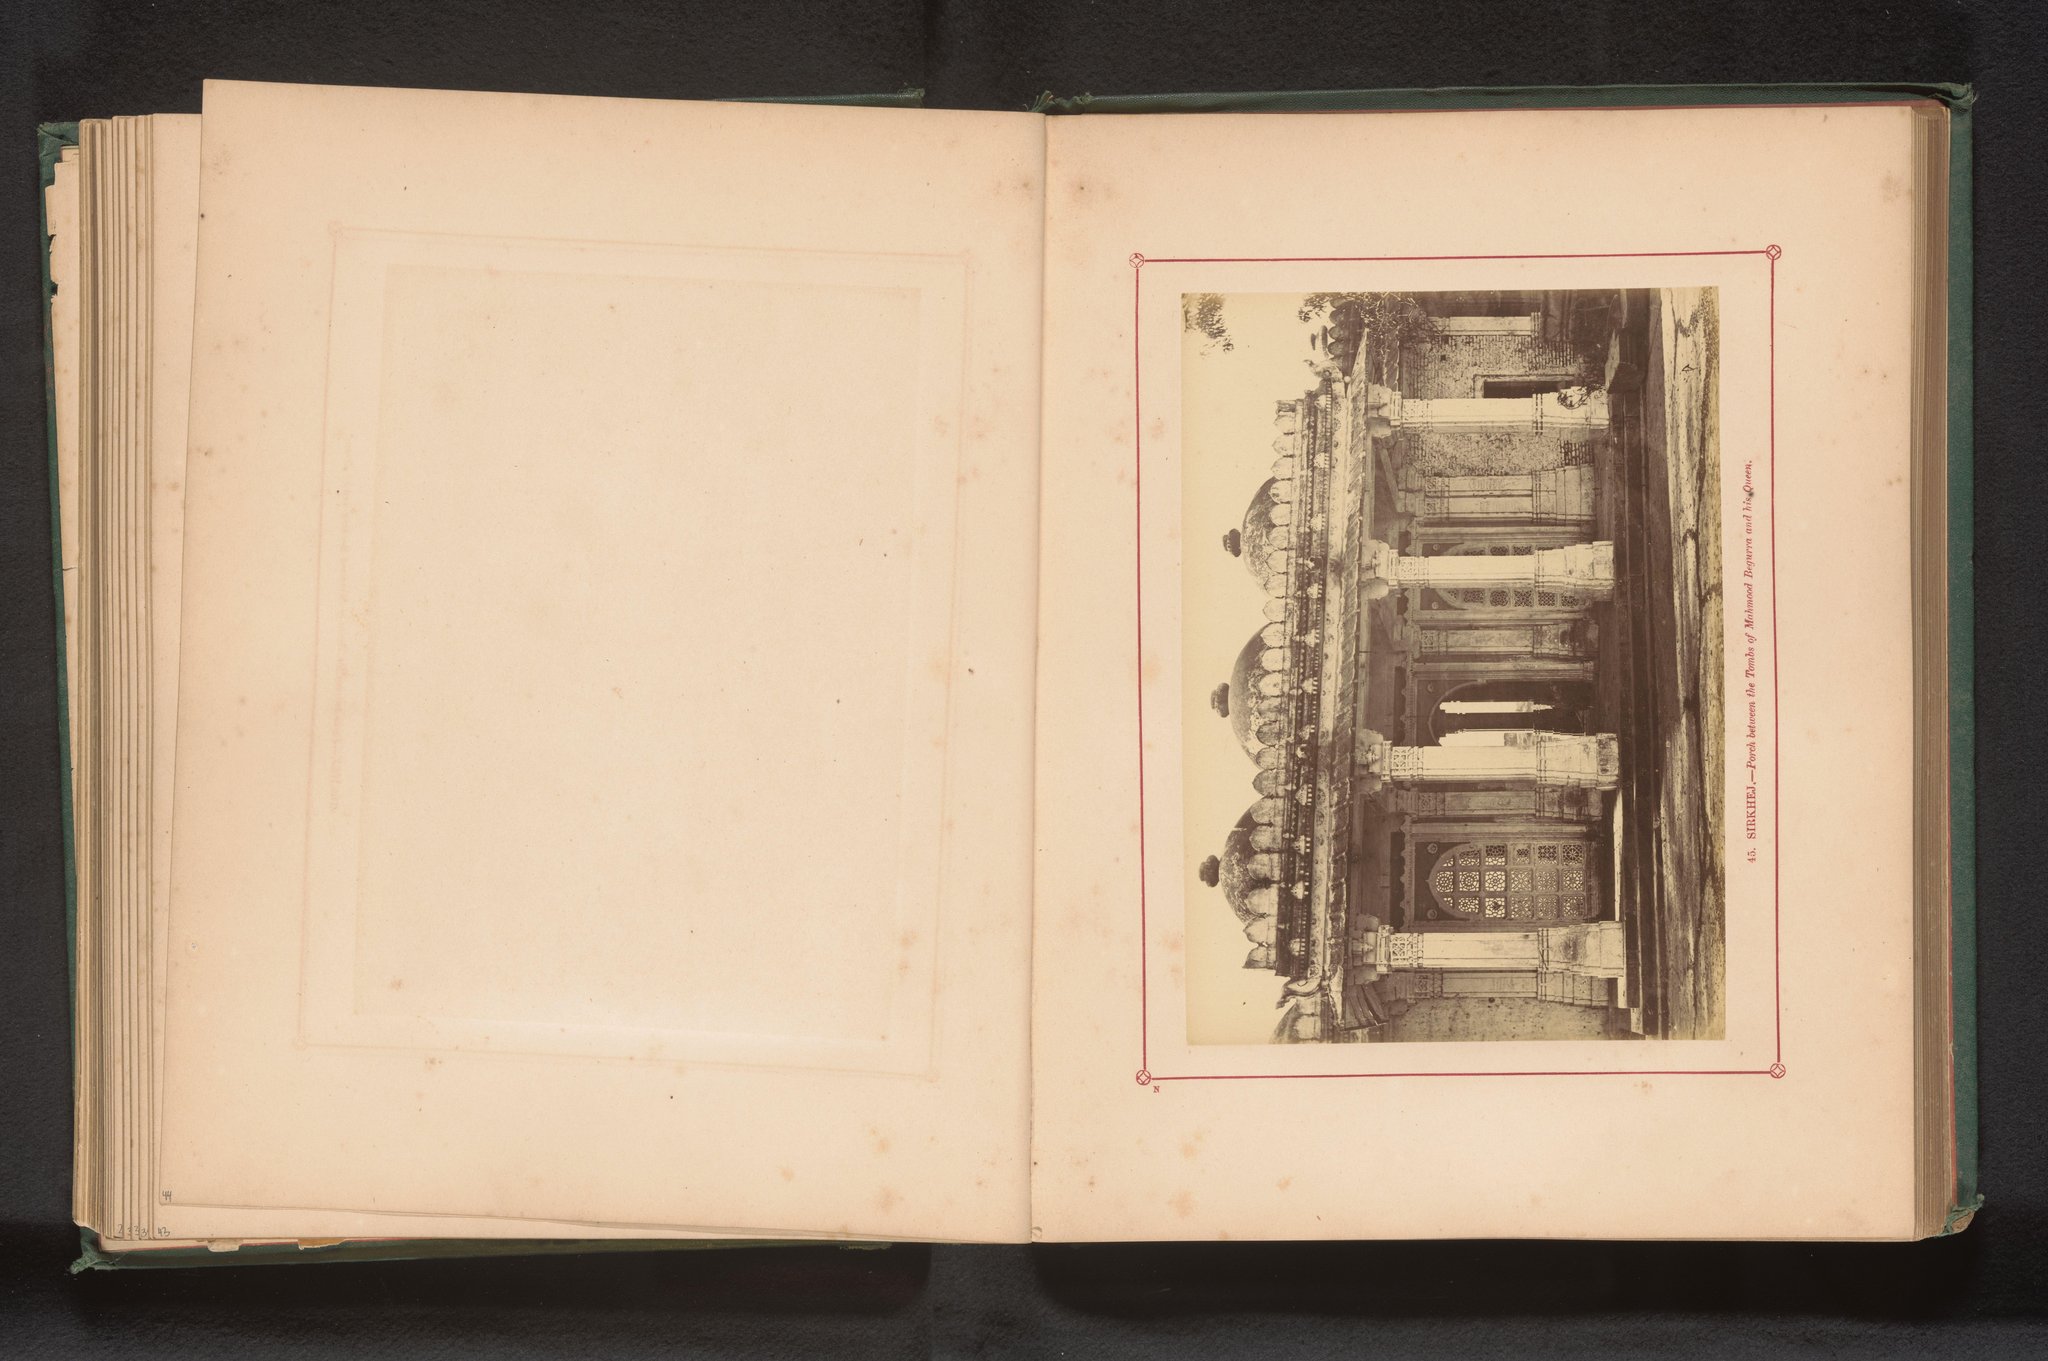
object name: page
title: Poort tussen de tombe van Mahmud Begada en de tombe van zijn vrouw op Sarkhej Roza bij Ahmedabad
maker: thomas biggs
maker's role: fotograaf, kapitein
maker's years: 1822-1905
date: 1856-1866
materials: photographic support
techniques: albumen print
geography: sarkhej roza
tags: grave, tomb, loggia, verandah, porch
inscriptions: number: ‘45.’, inscription: ‘N’